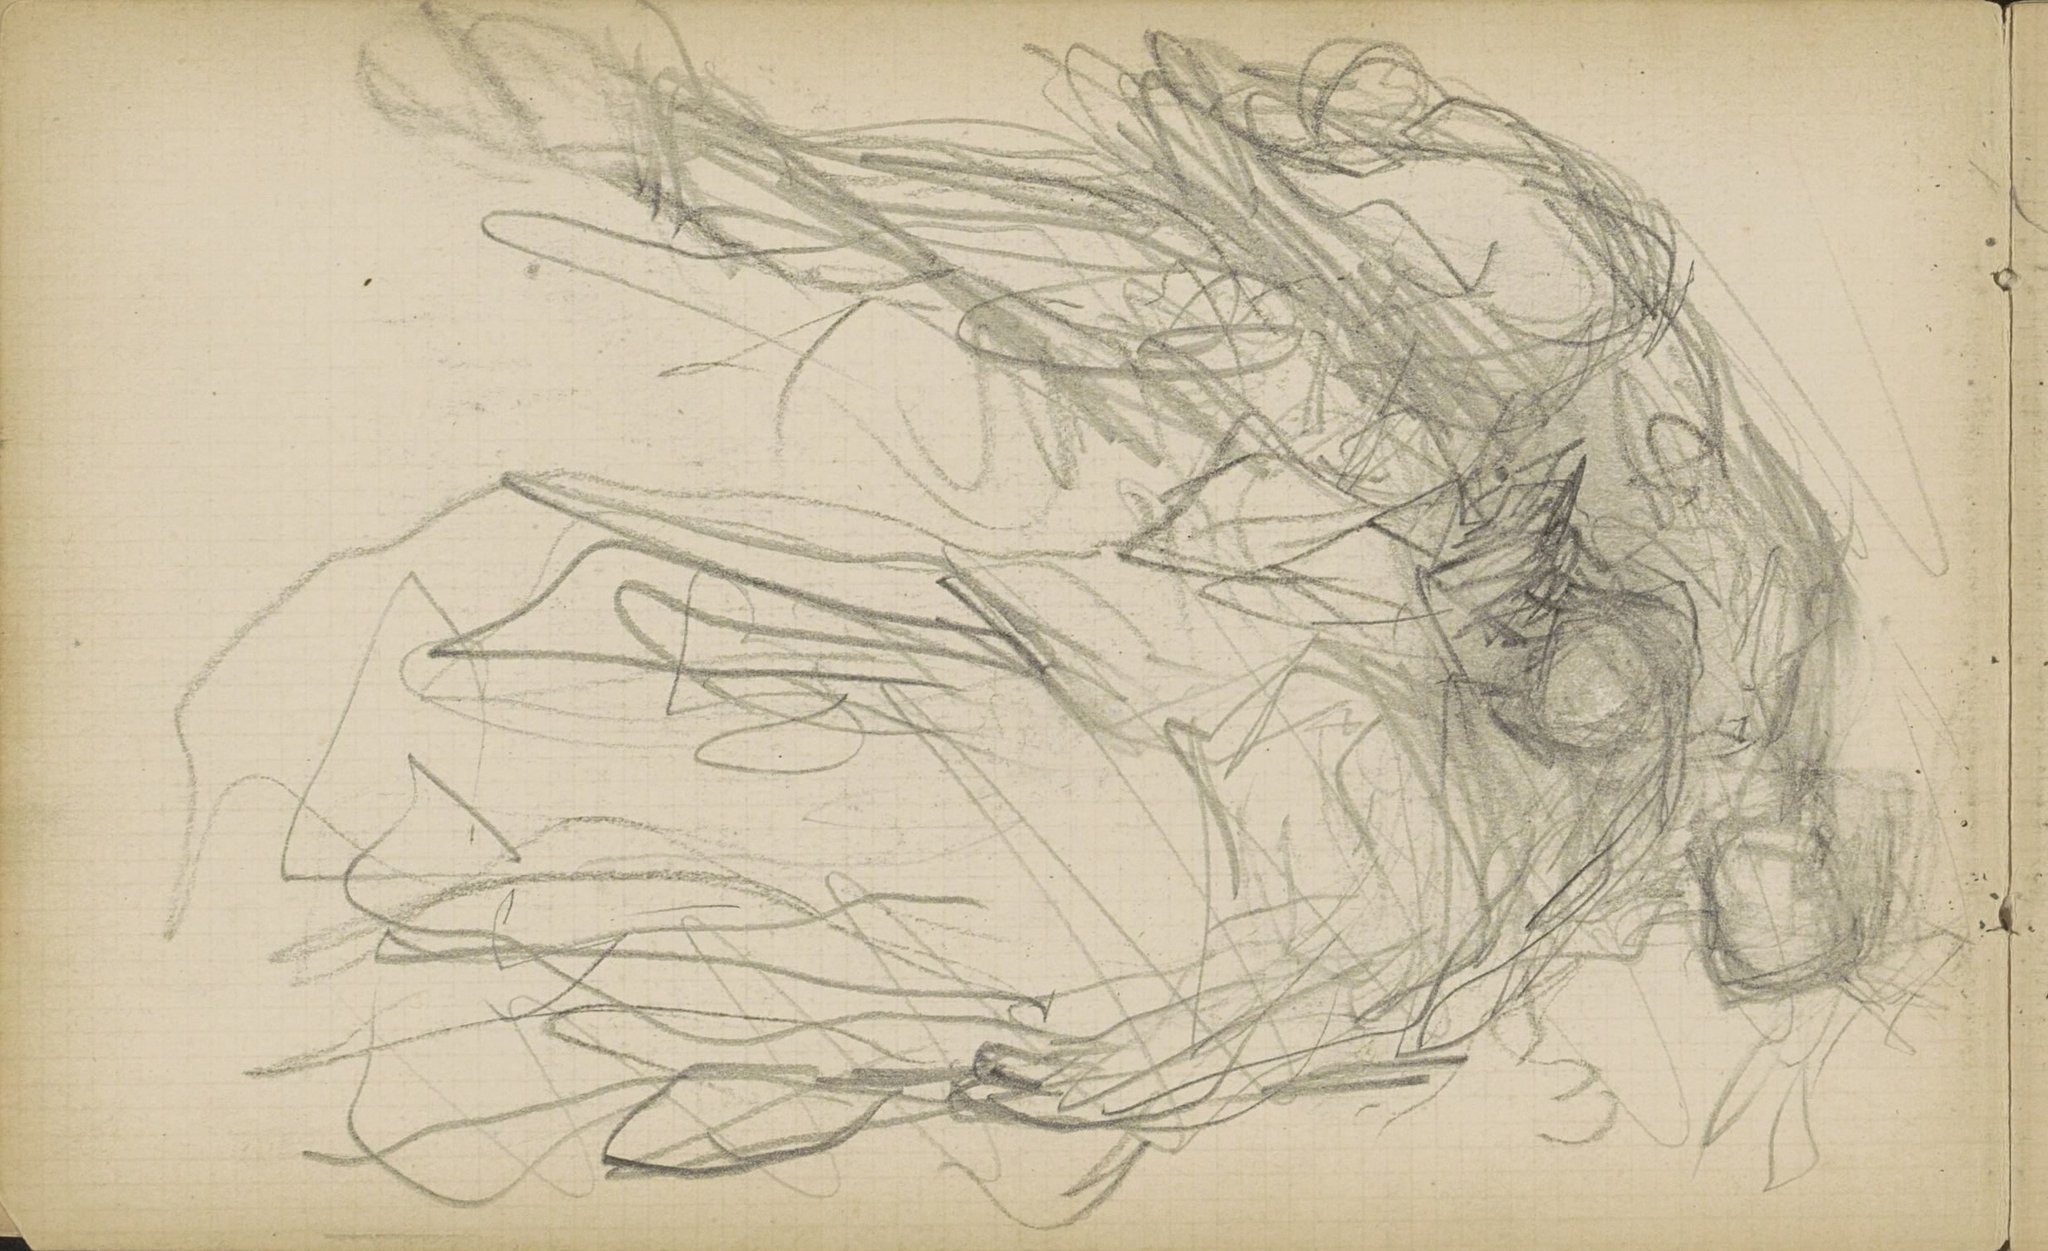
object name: sketchbook leaf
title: Twee figuren, leunend met de hoofden dicht bij elkaar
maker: matthijs maris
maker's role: draughtsman, painter, print maker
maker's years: 1839-1917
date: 1849-1917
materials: pencil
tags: leaning figure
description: Blad 13 verso uit een schetsboek met 35 bladen.